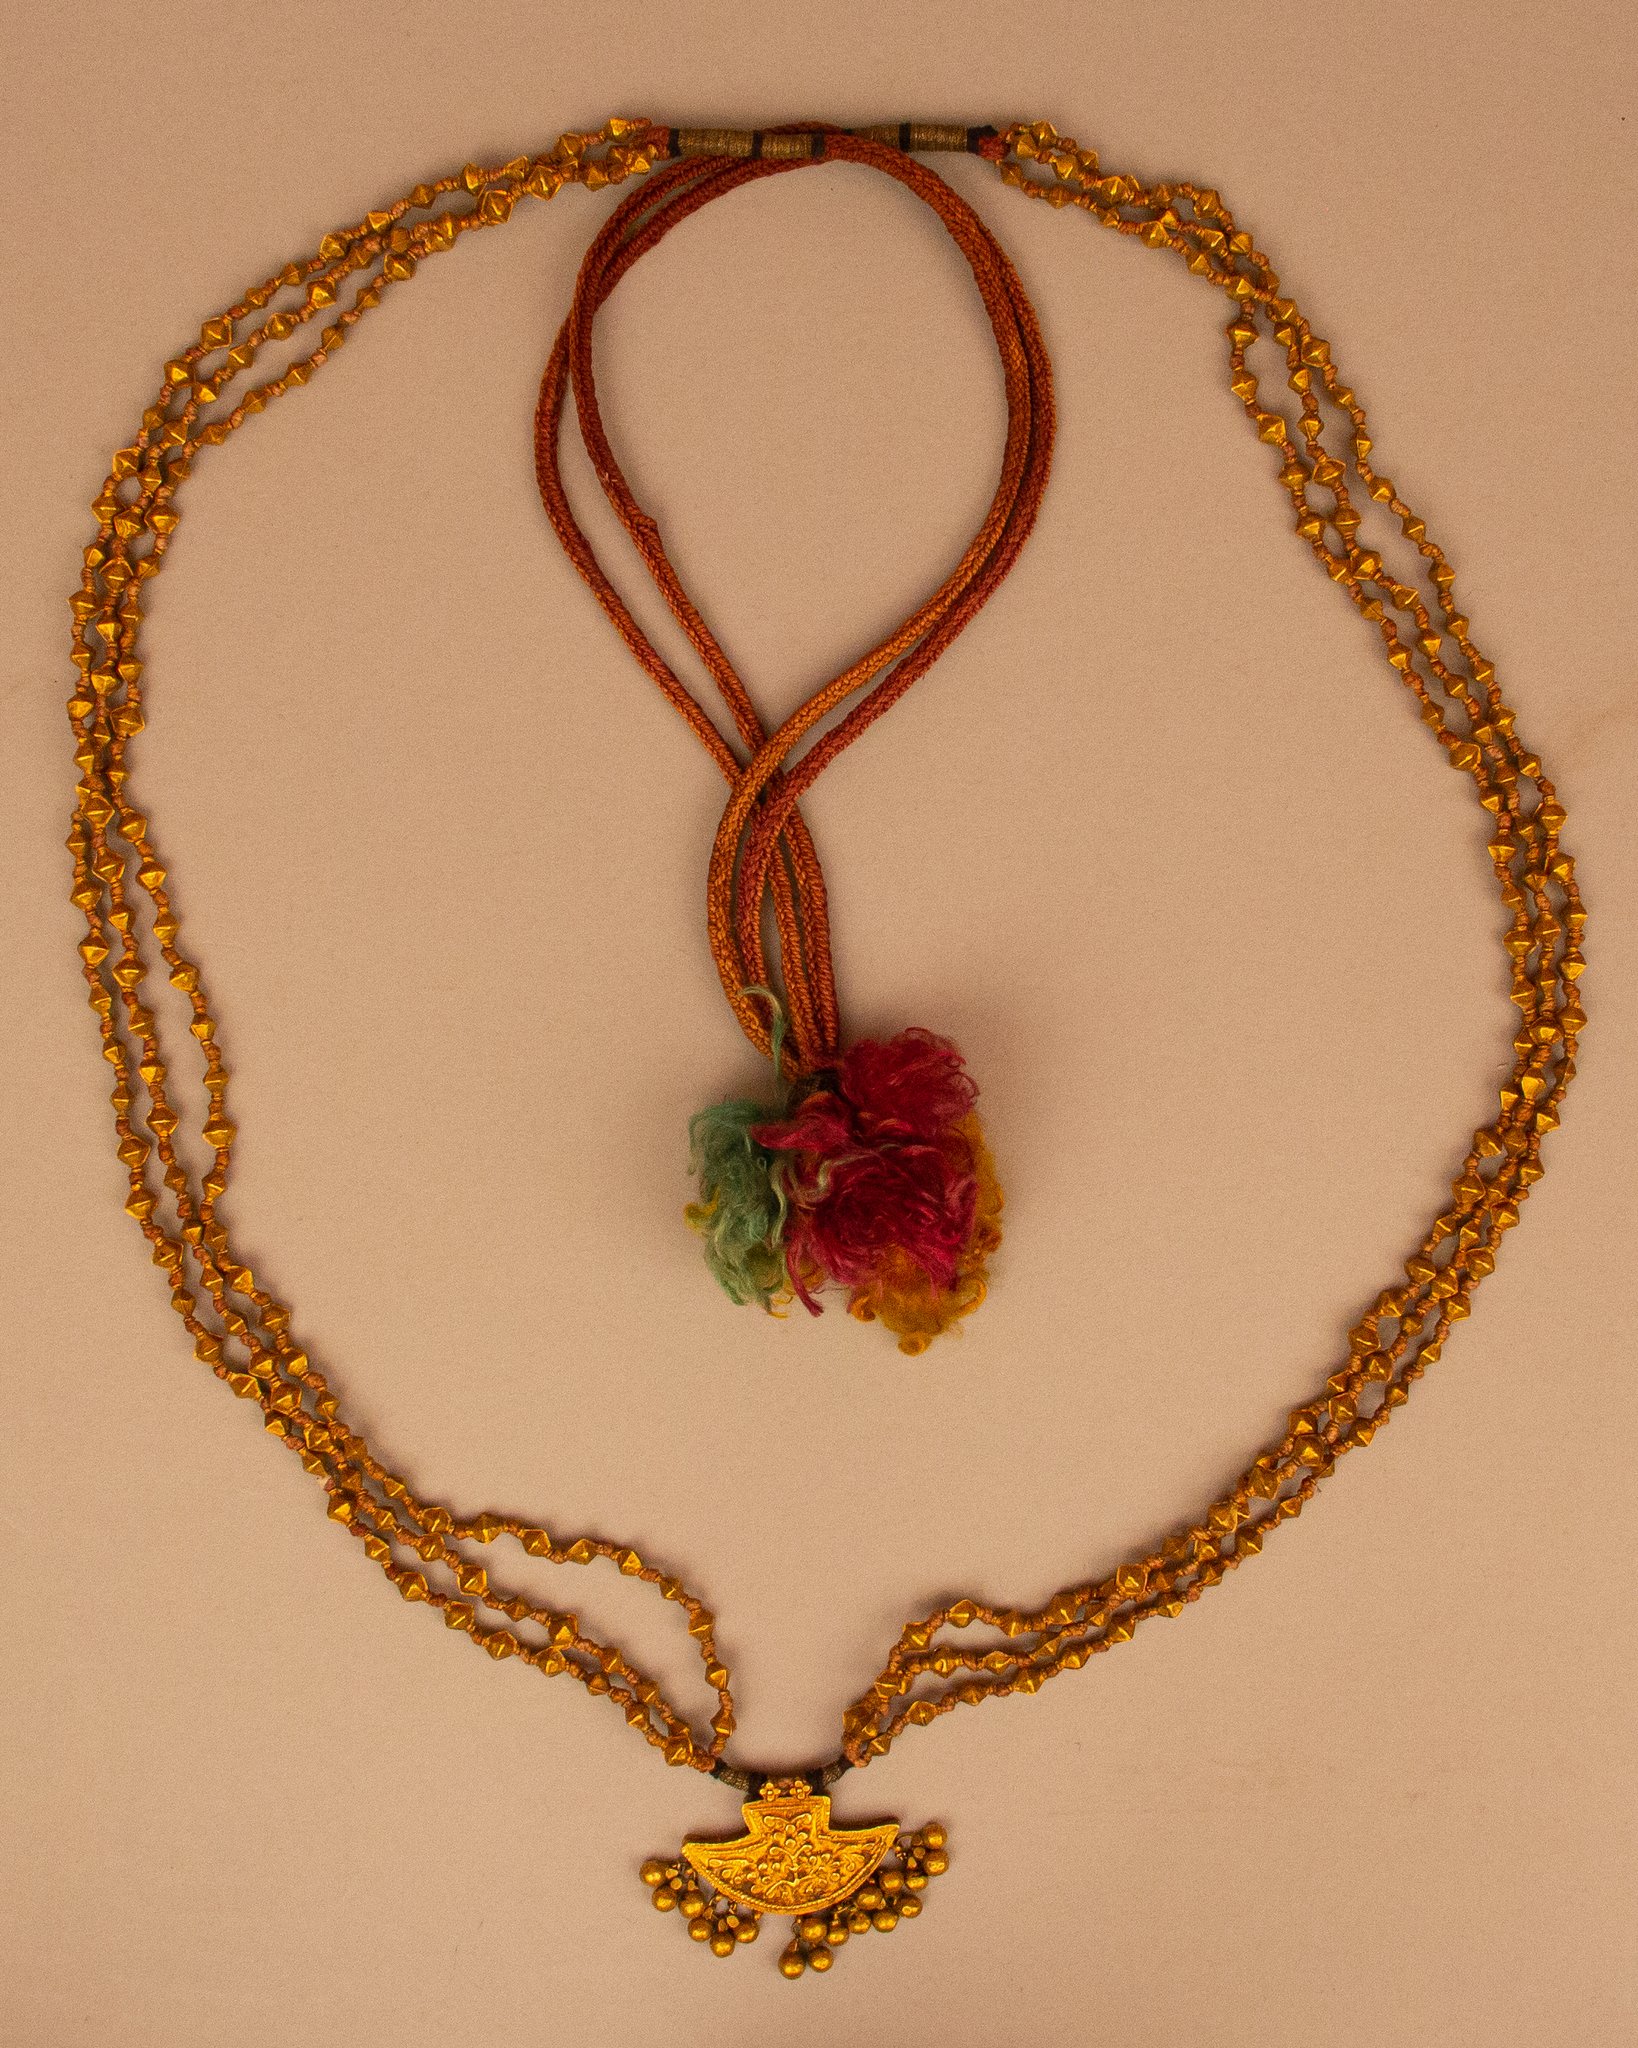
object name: necklace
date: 1701-1900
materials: gold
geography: india